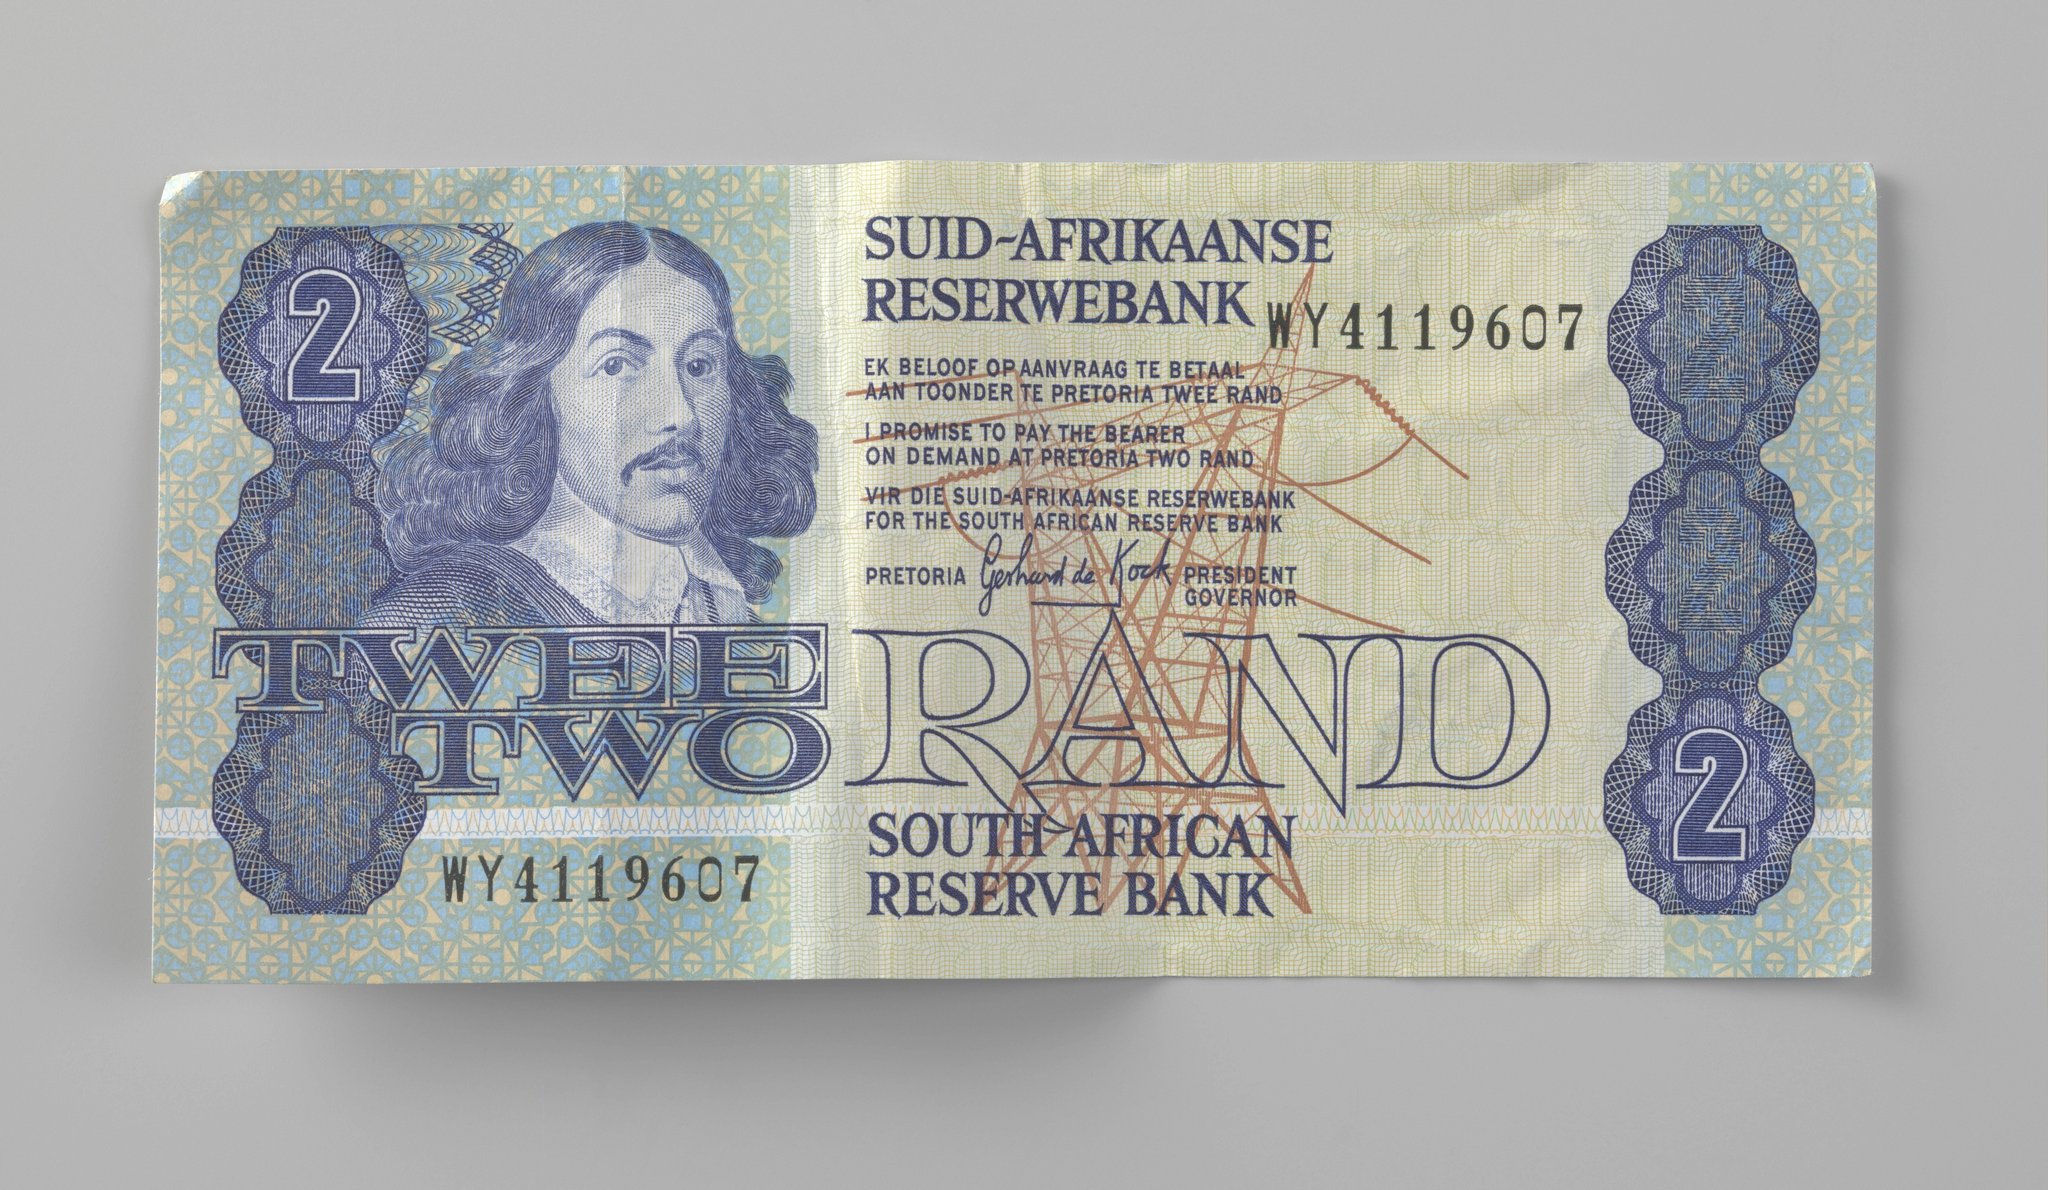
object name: waardepapier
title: Bankbiljet van twee Zuid-Afrikaanse rand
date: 1981-1990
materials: paper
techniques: printing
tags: batavia